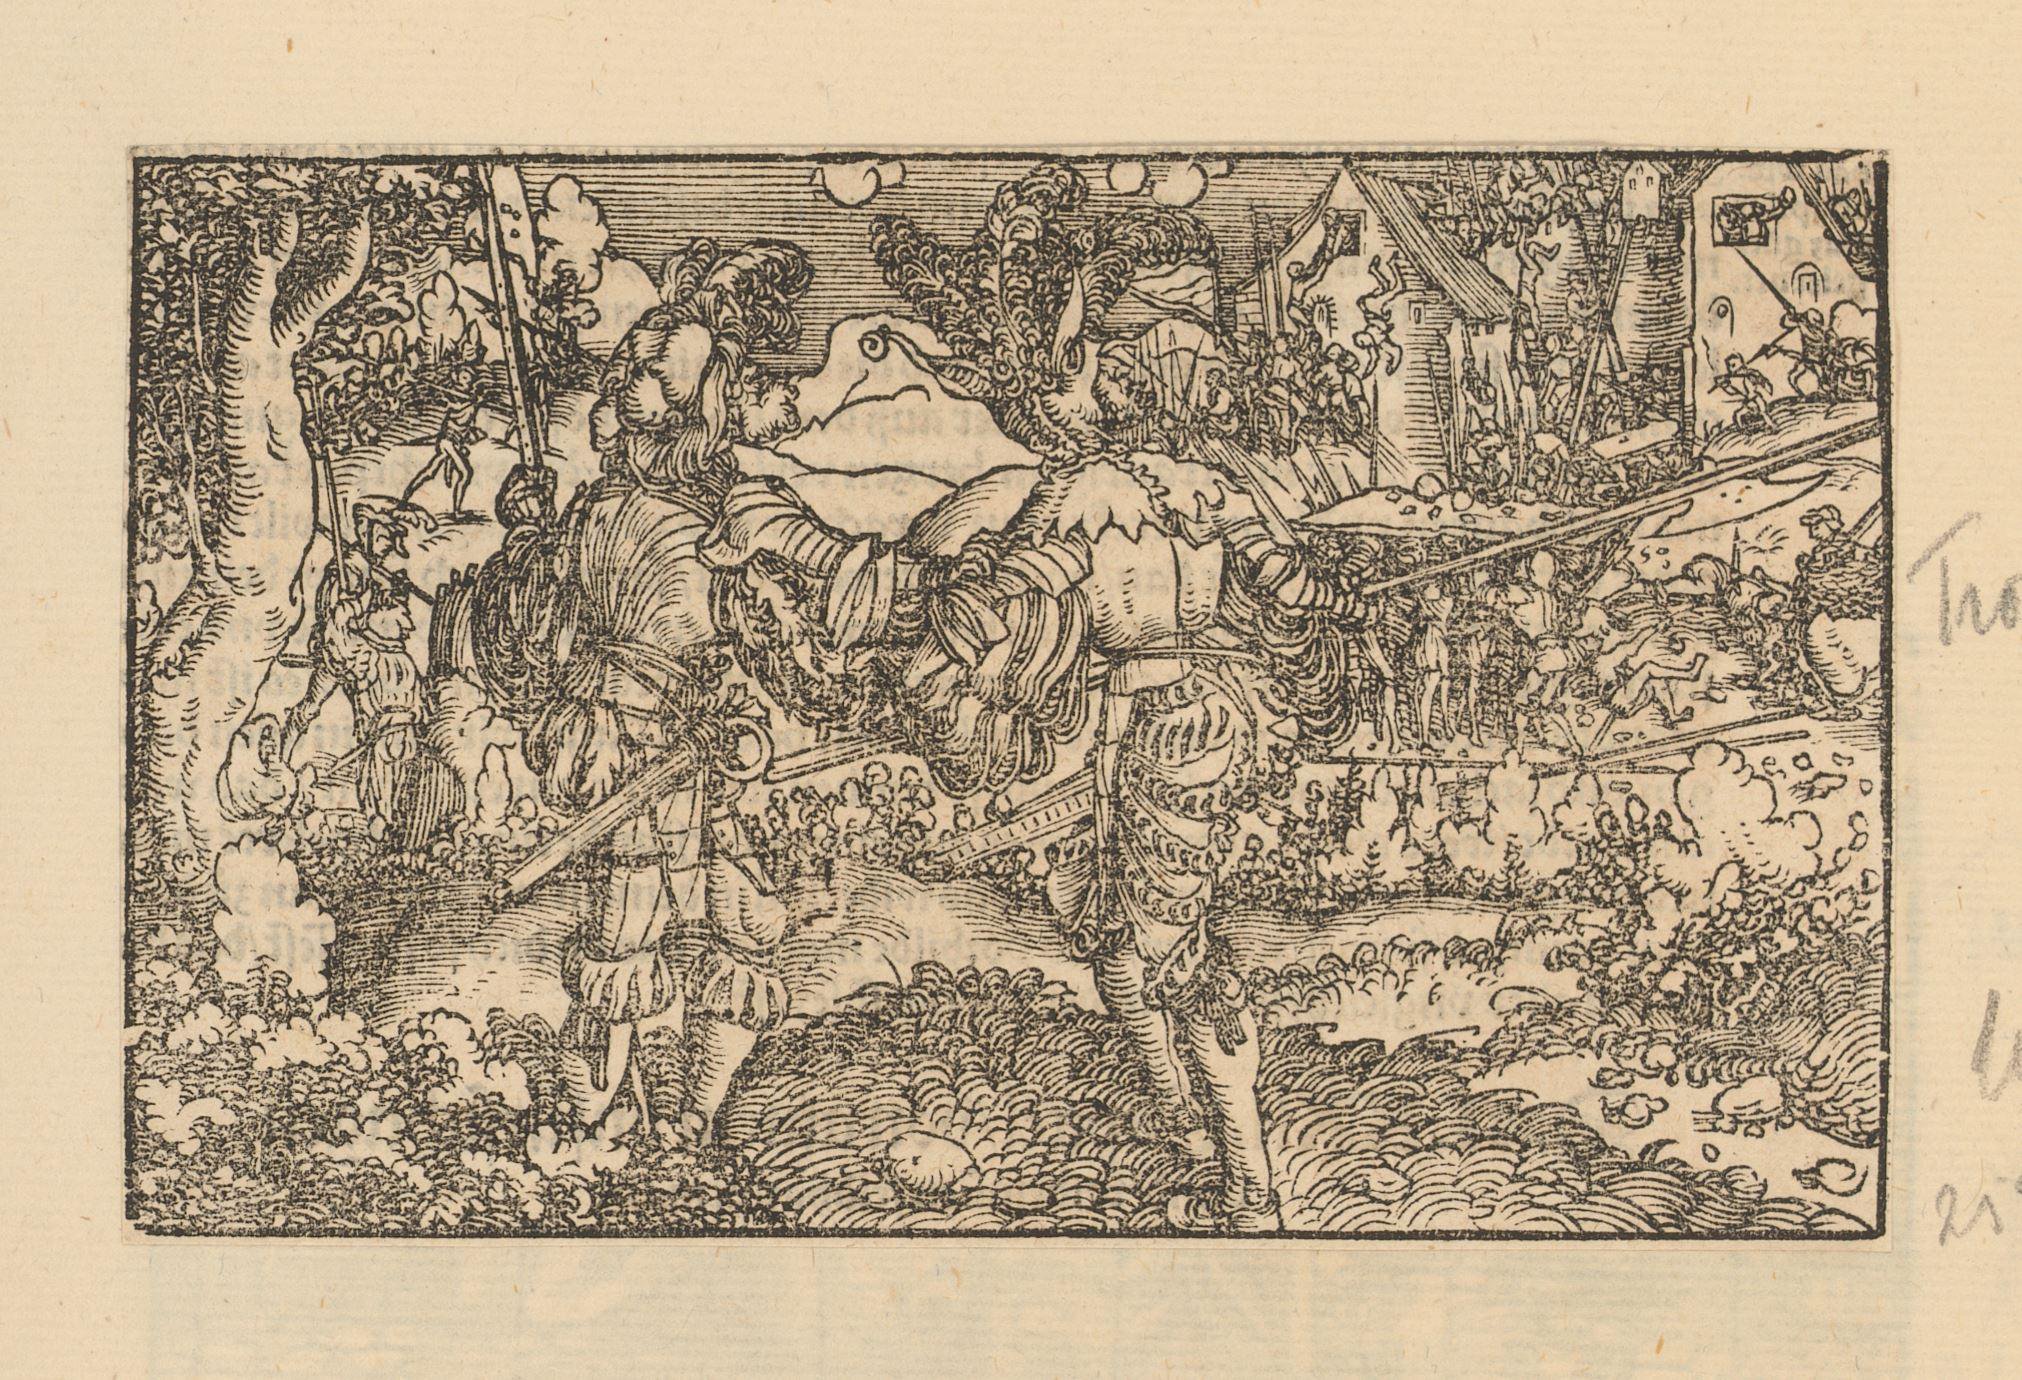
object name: album leaf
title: Twee soldaten en de belegering van een stad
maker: Anonymous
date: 1514-1532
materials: paper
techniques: letterpress printing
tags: private soldier, siege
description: Deze prent is gebruikt in: Petrarca, Francesco. Von der Artzney bayder Glück, des guten und widerwertigen: unnd weß sich ain yeder inn Gelück und Unglück halten sol (...). Augsburg: Heinrich Steiner, 1532. Deze uitgave is ook bekend onder de titel 'Trostspiegel in Glück und Unglück'.